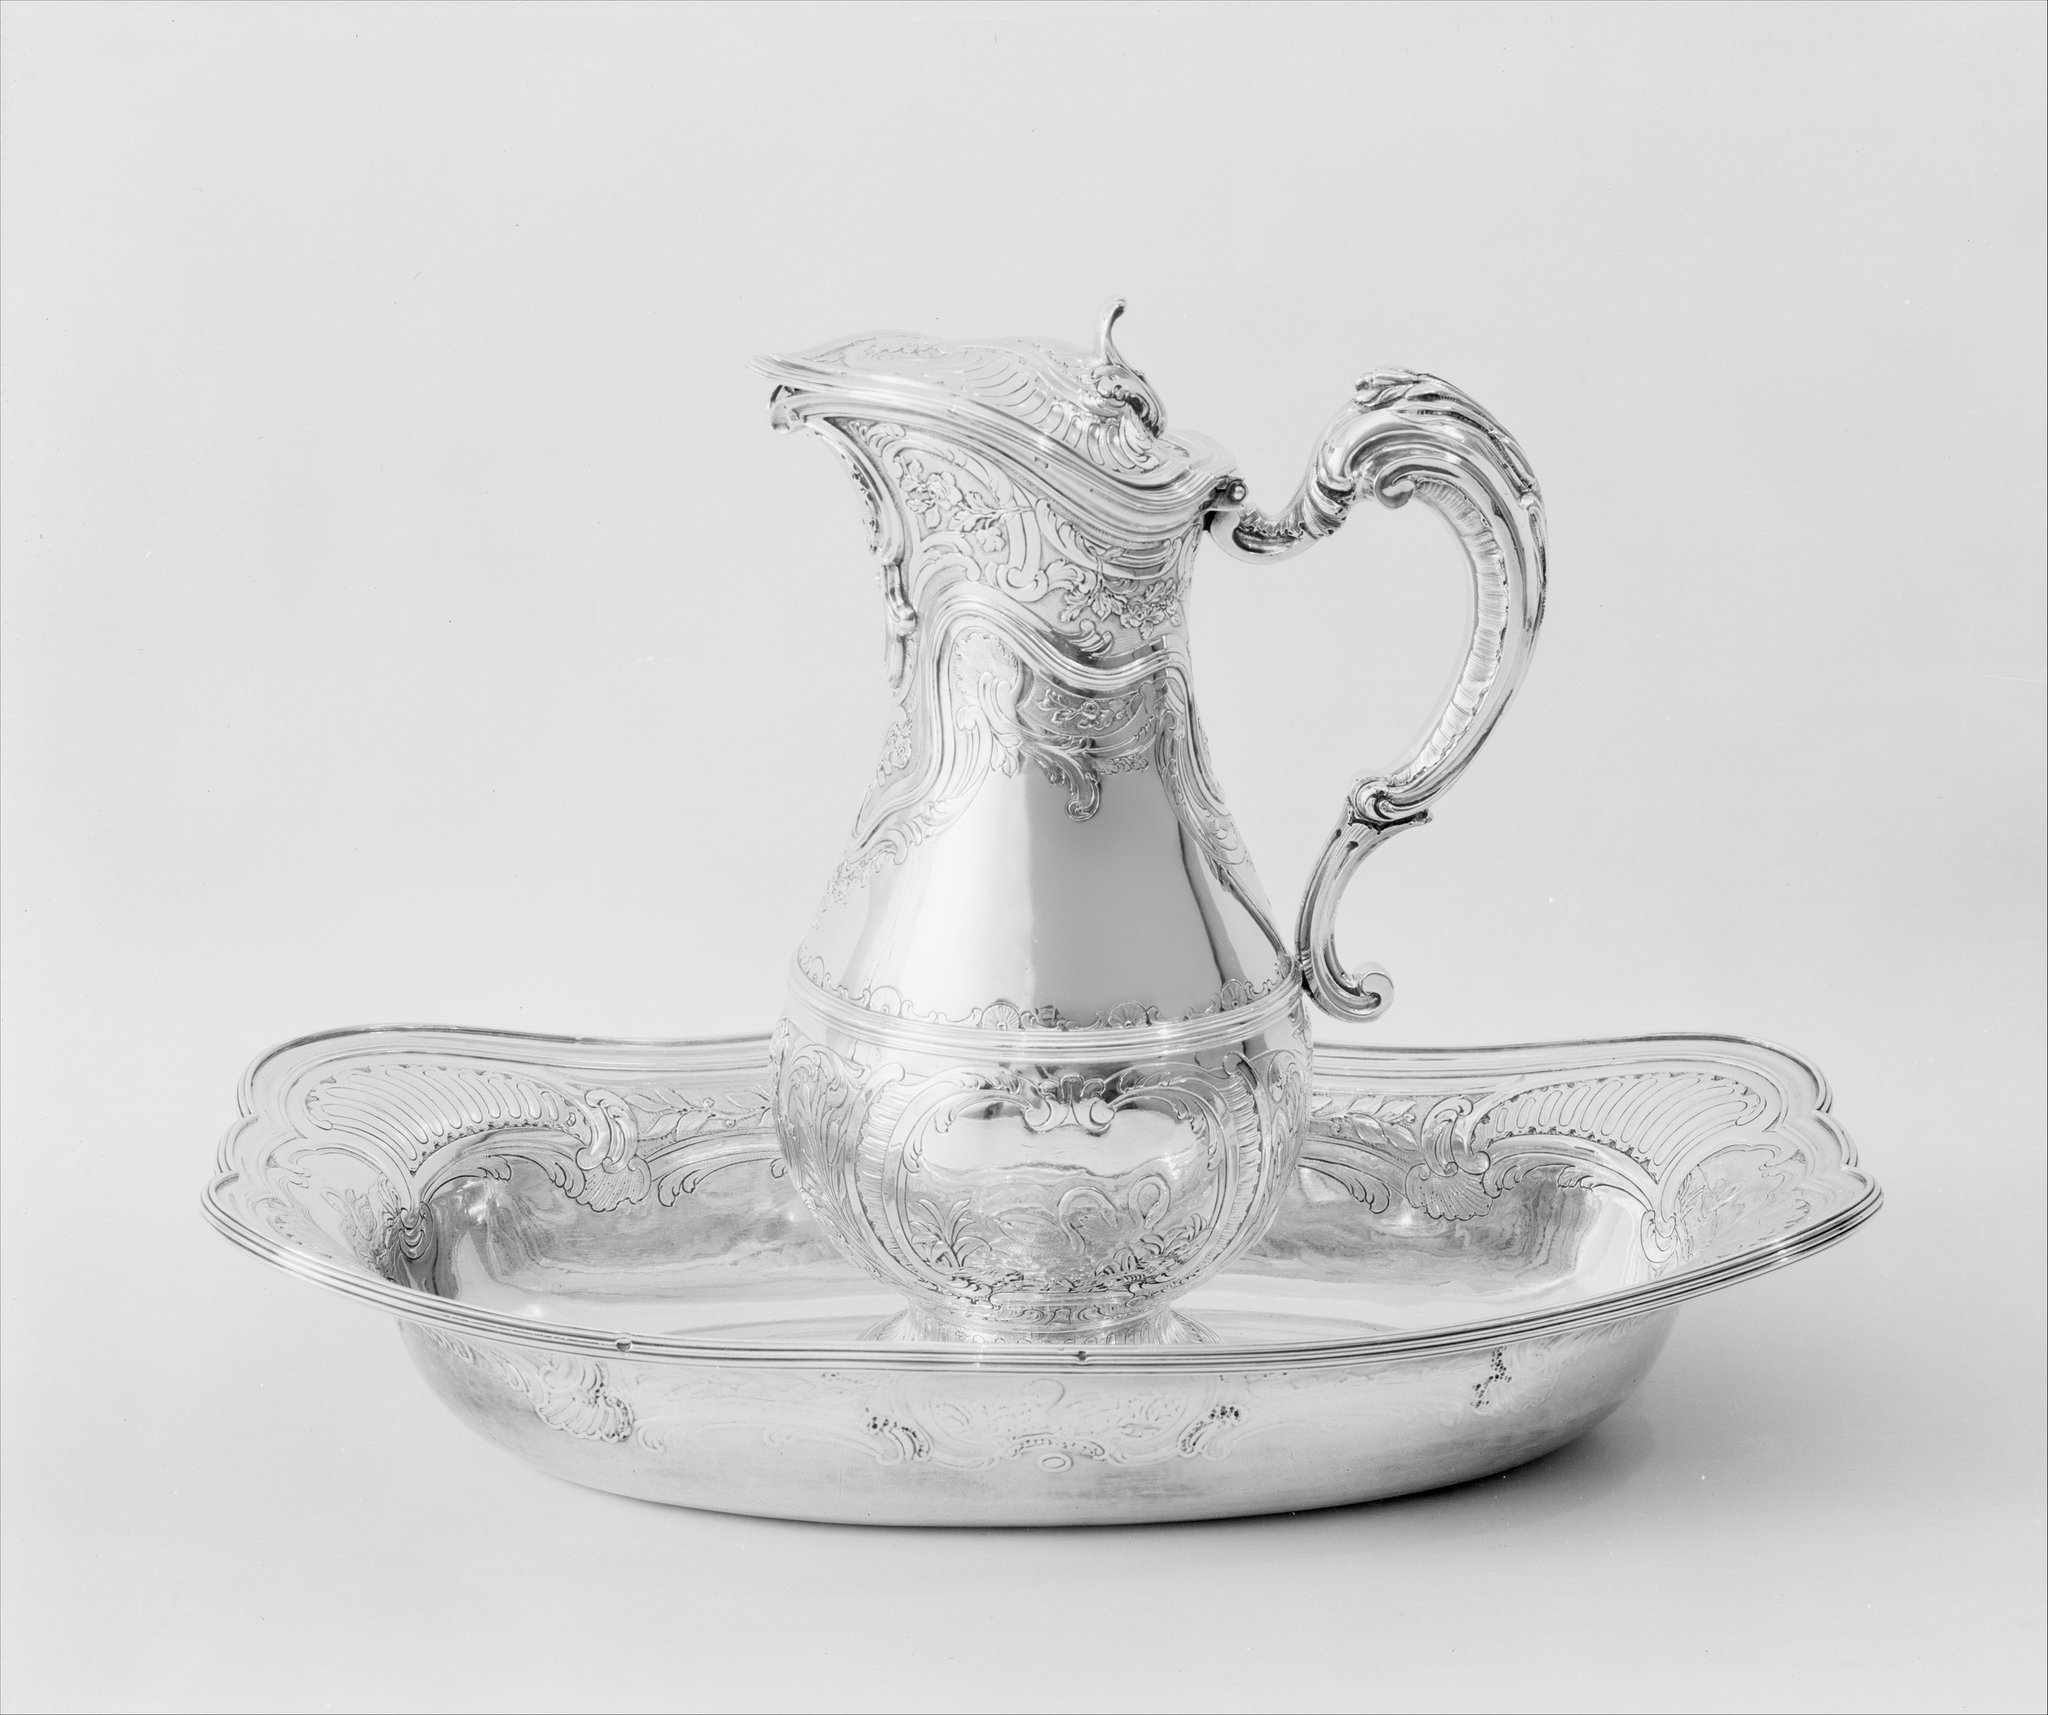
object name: ewer and basin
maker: joseph-pierre-jacques duguay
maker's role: maker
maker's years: 1724-1824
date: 1761-1762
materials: silver